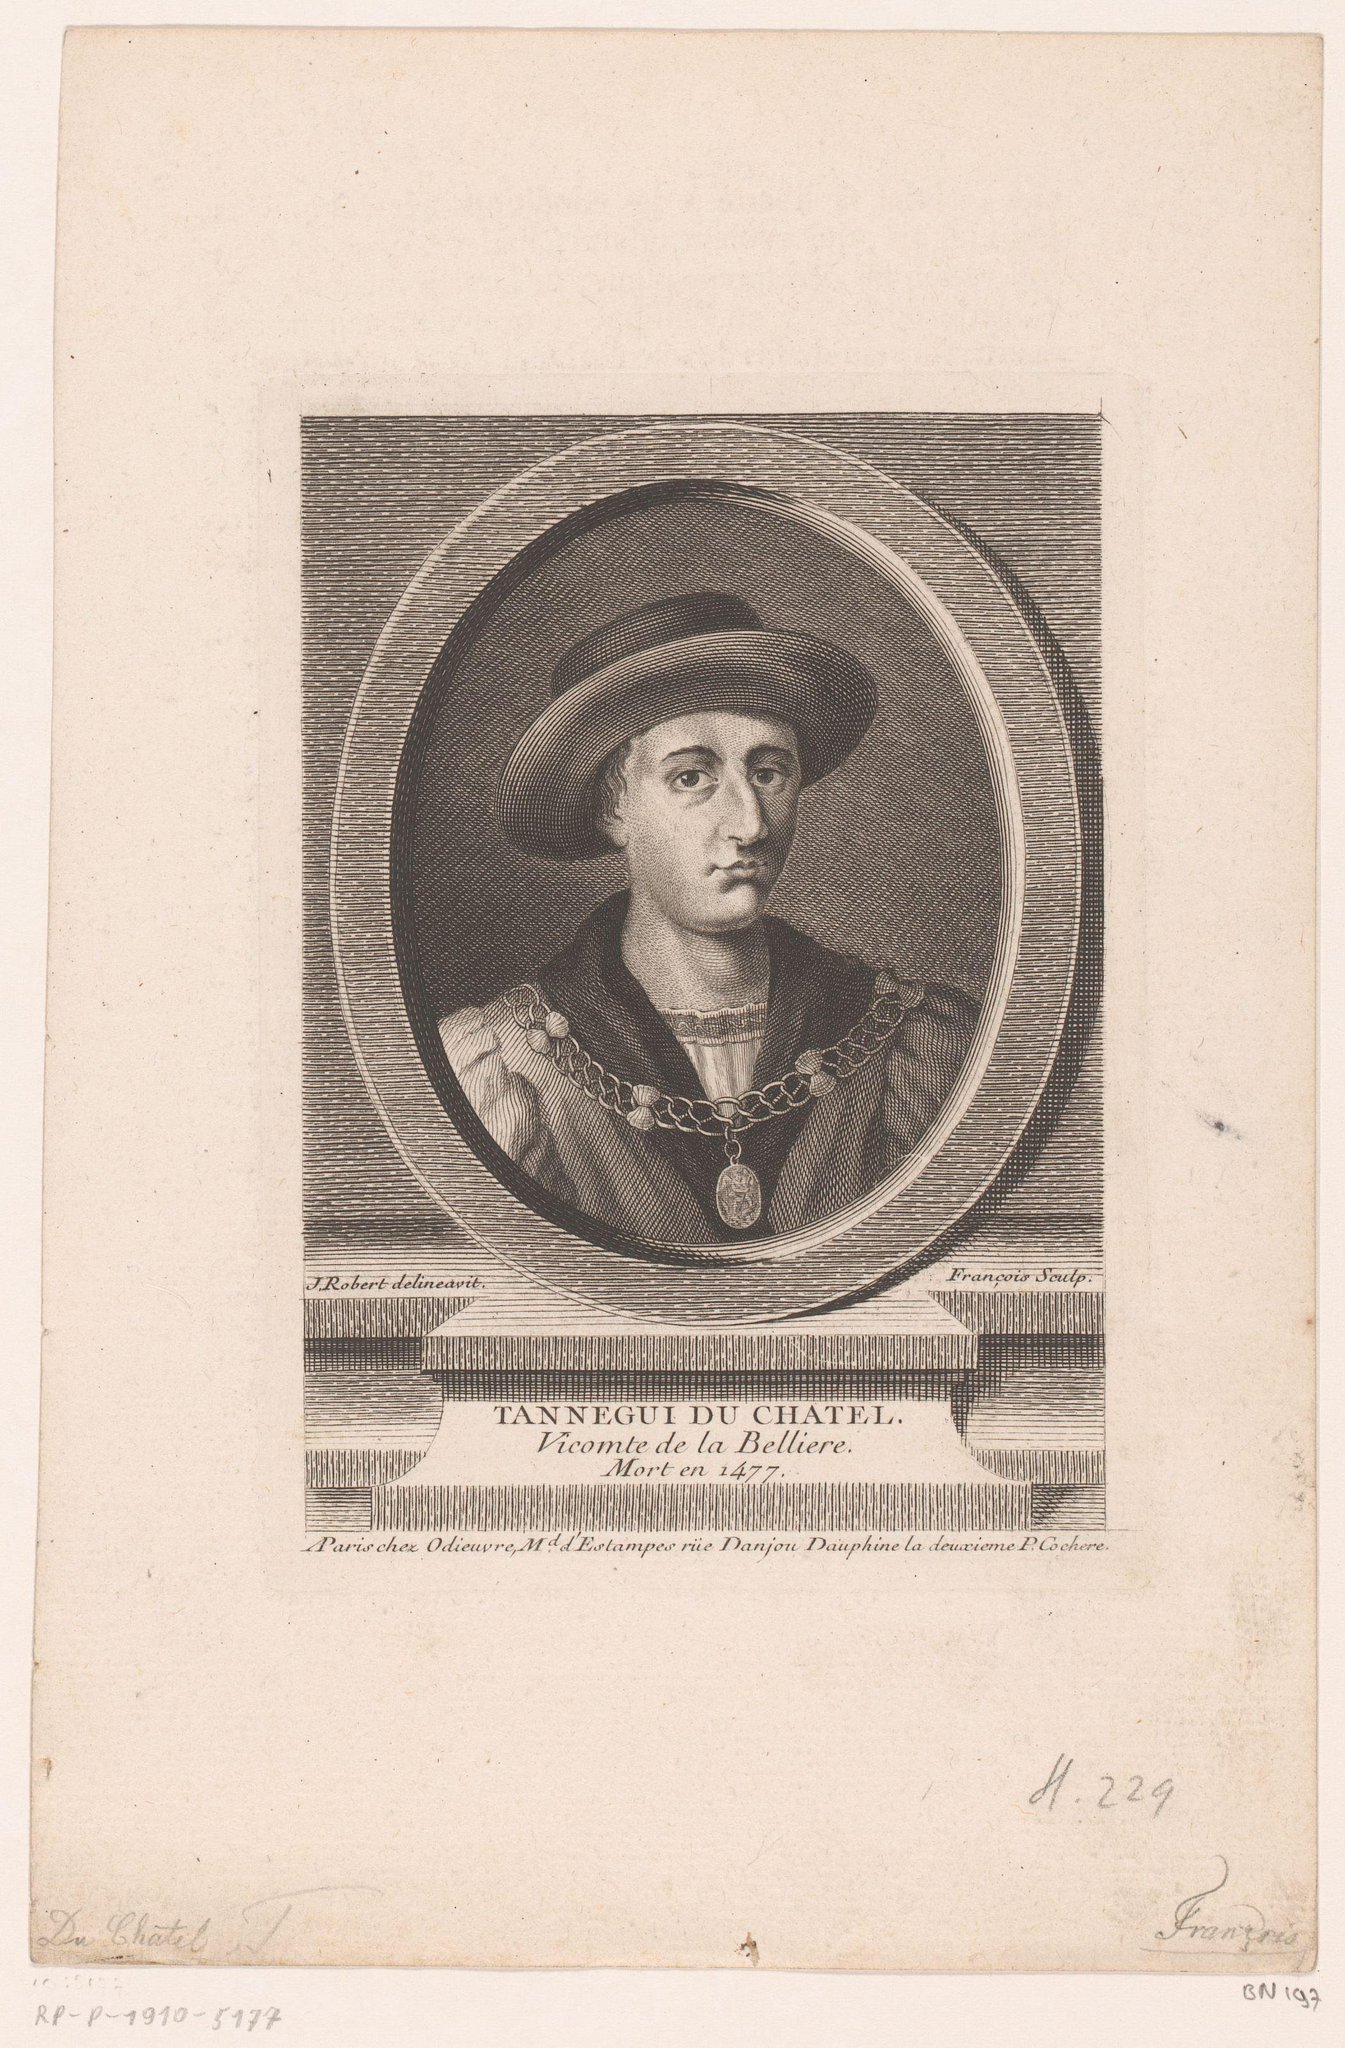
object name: book illustration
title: Tannegui du Chatel.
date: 1755-1766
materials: paper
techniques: engraving, etching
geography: paris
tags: historical persons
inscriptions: collector's mark: Lugt 2228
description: Prent uit: Dreux du Radier, Jean-François. L'Europe illustré, contenant l'histoire abregée des souverains, des princes, des prélats, des ministres, (...) en Europe: dans le XVe. siècle compris, jusqu'à présent. Parijs: Michel Odieuvre en Jean-Luc Nyon, 1755-1765.